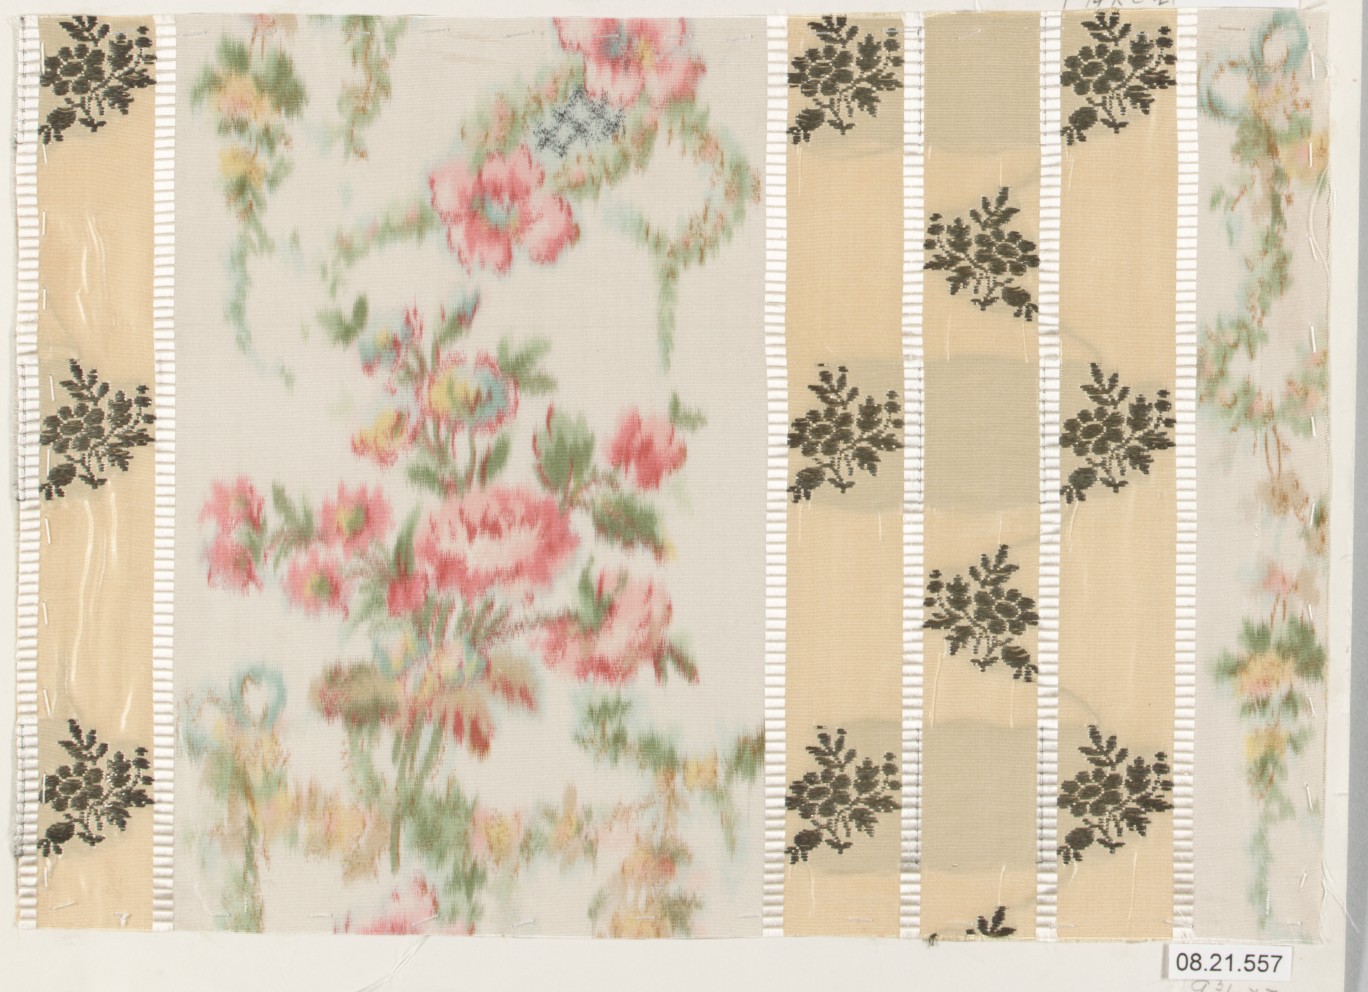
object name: textile sample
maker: Anonymous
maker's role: designer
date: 1900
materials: silk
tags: flowers